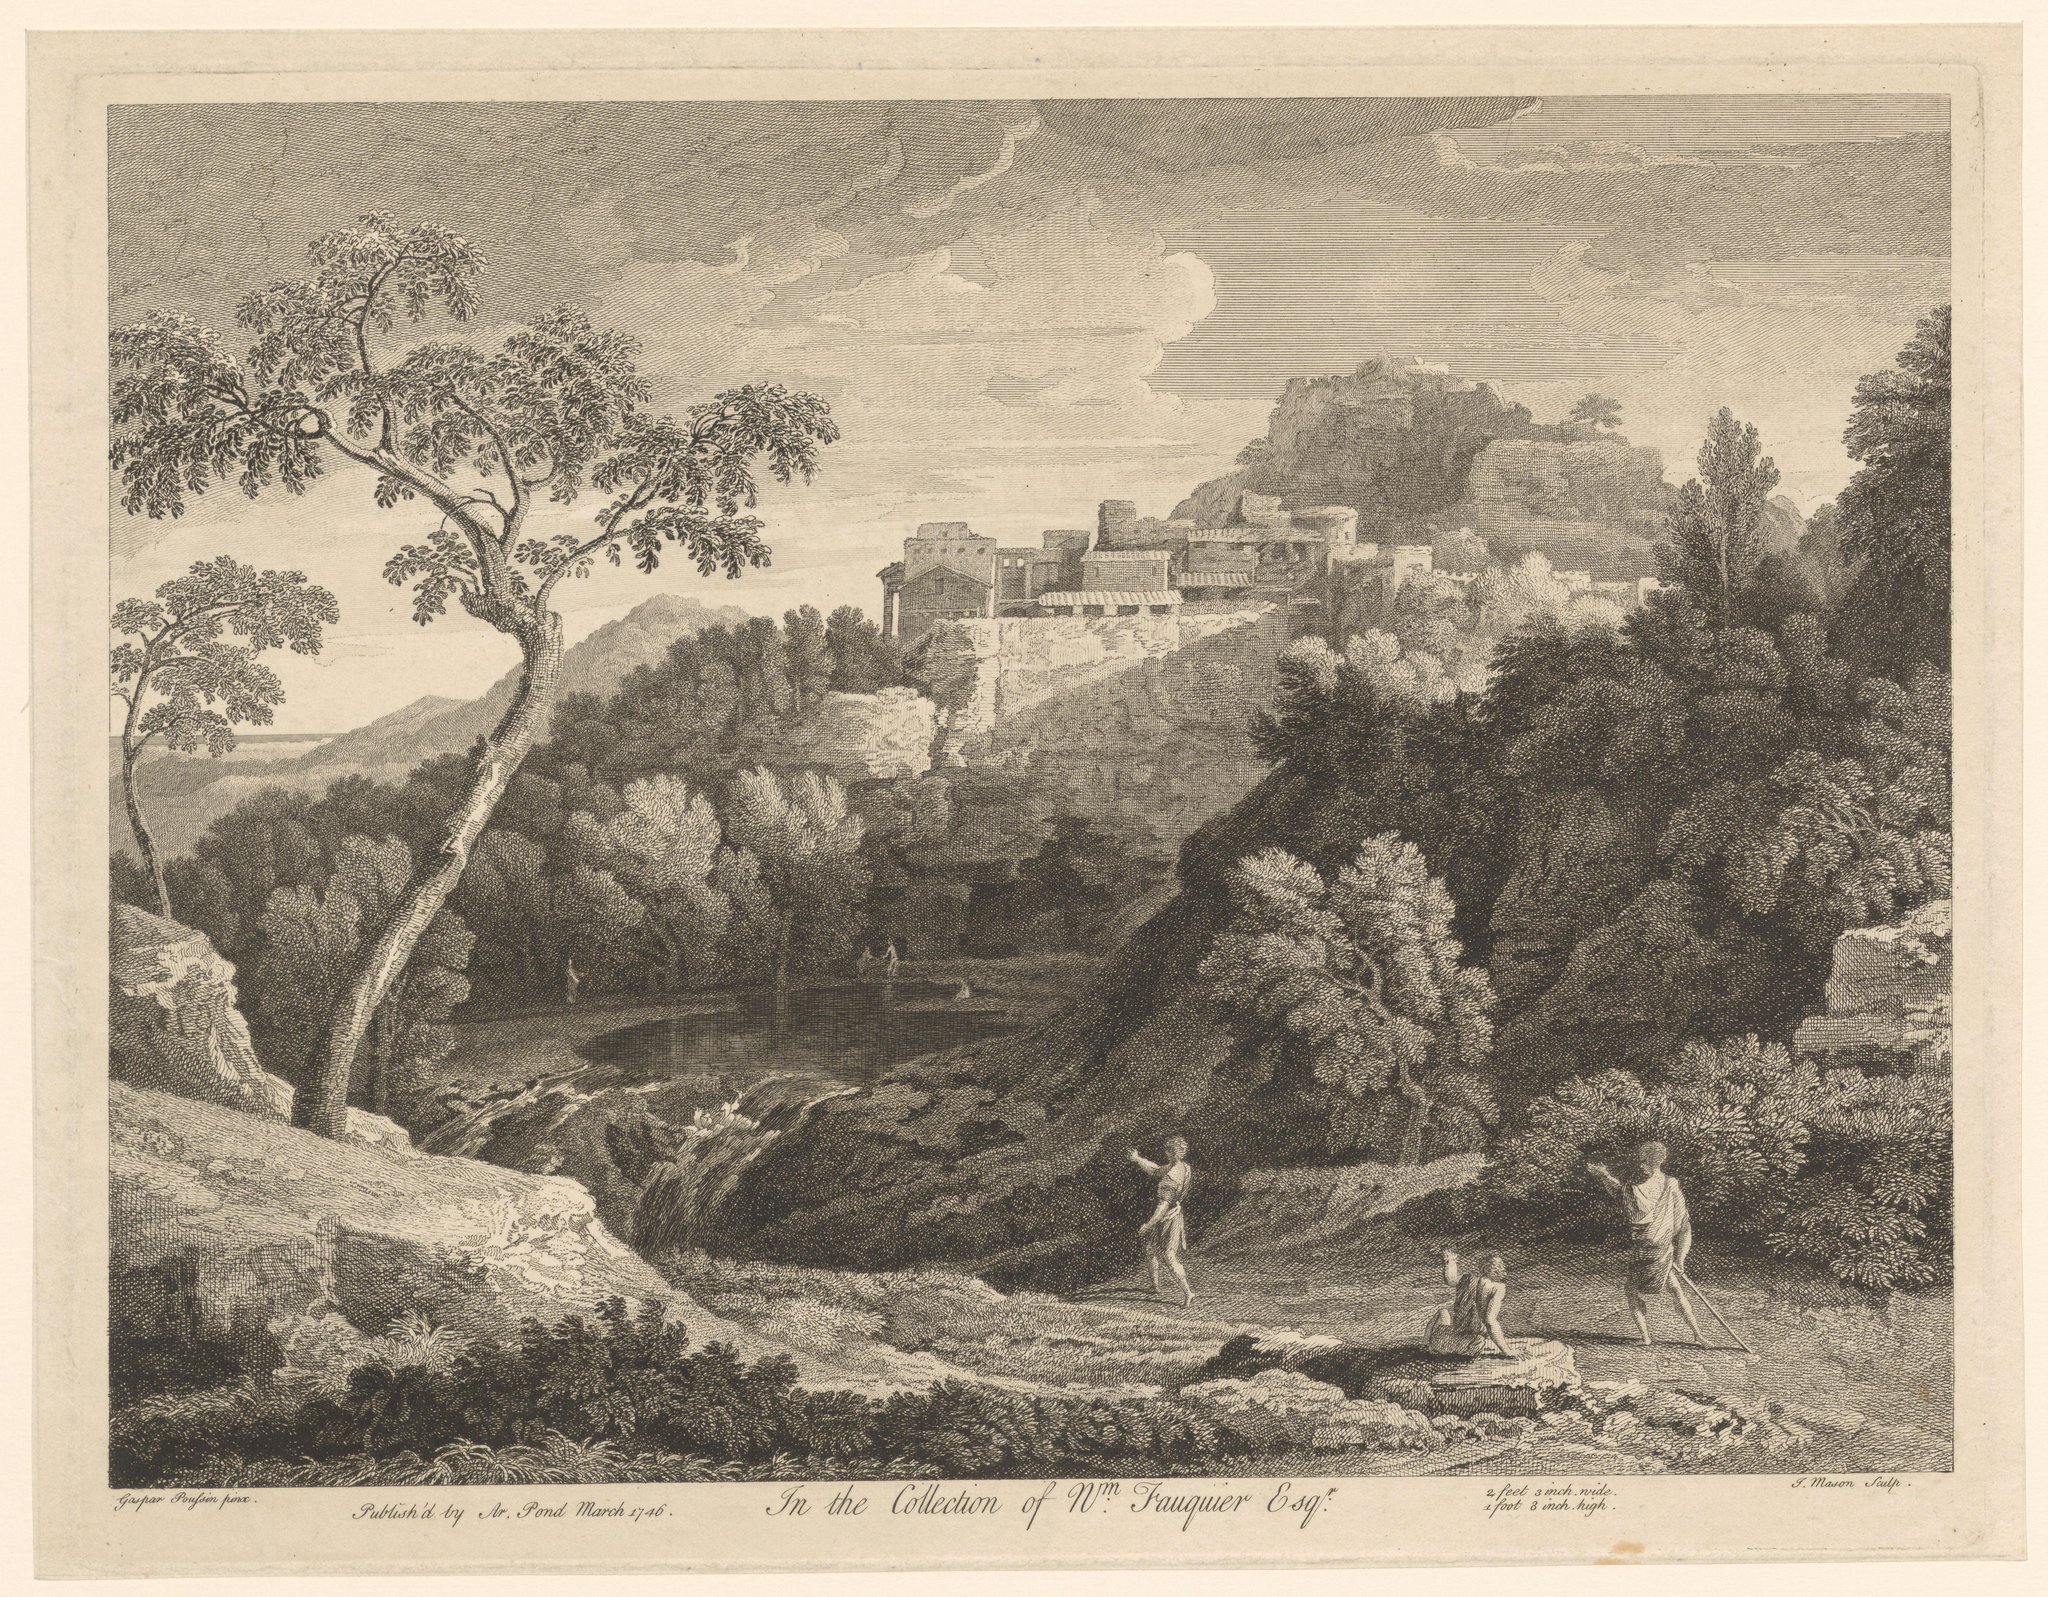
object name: print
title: Italian landscapes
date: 1703-1746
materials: paper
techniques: etching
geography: london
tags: trees, (high) hill, village, lake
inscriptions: collector's mark: Lugt 240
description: De serie werd tussen 1741 en 1746 door Knapton en Pond uitgegeven.